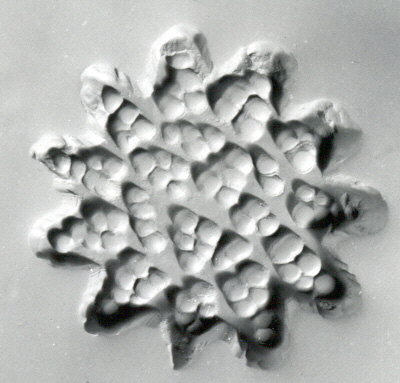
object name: stamp seal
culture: bactria-margiana archaeological complex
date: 2333-1668 BCE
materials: marble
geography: bactria-margiana